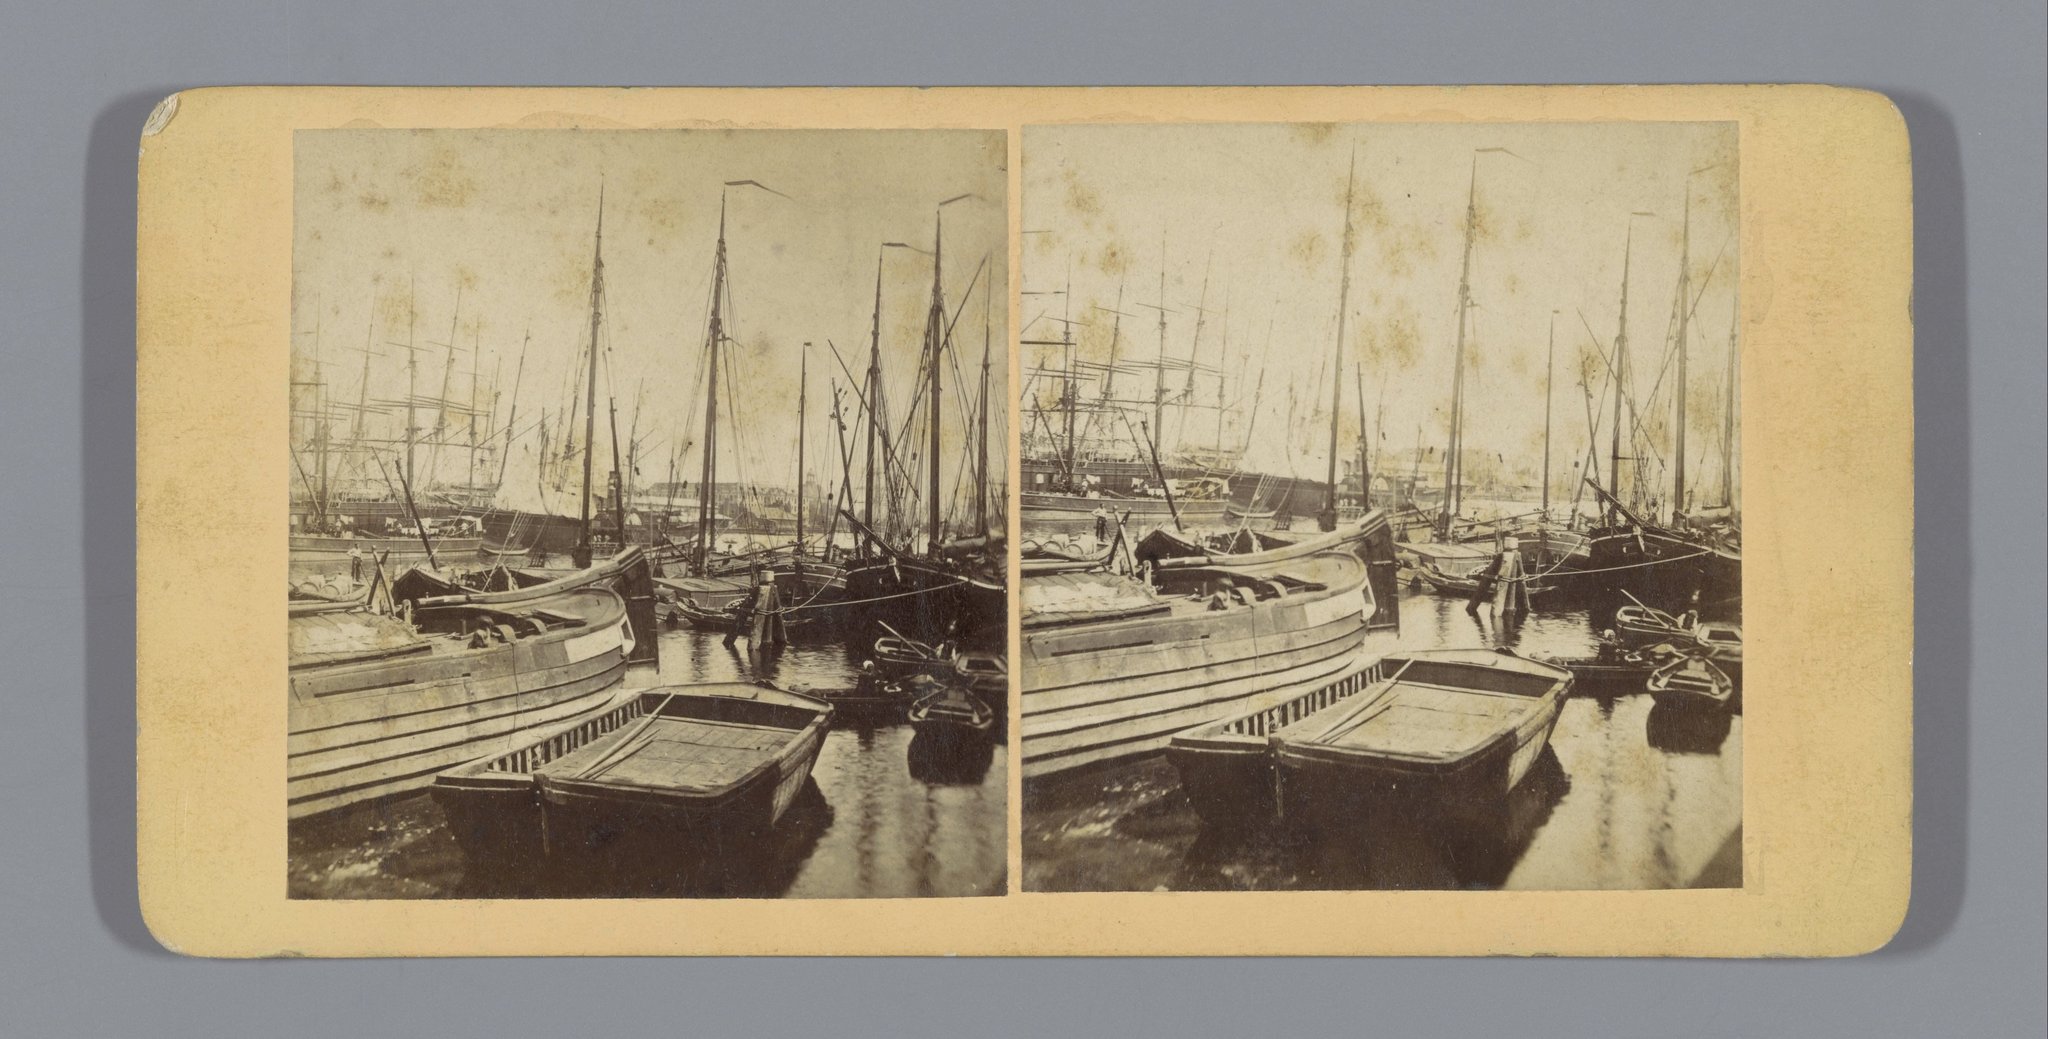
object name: stereograph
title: Oosterdok, Amsterdam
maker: Anonymous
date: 1868-1890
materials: cardboard, paper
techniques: albumen print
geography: amsterdam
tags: harbour